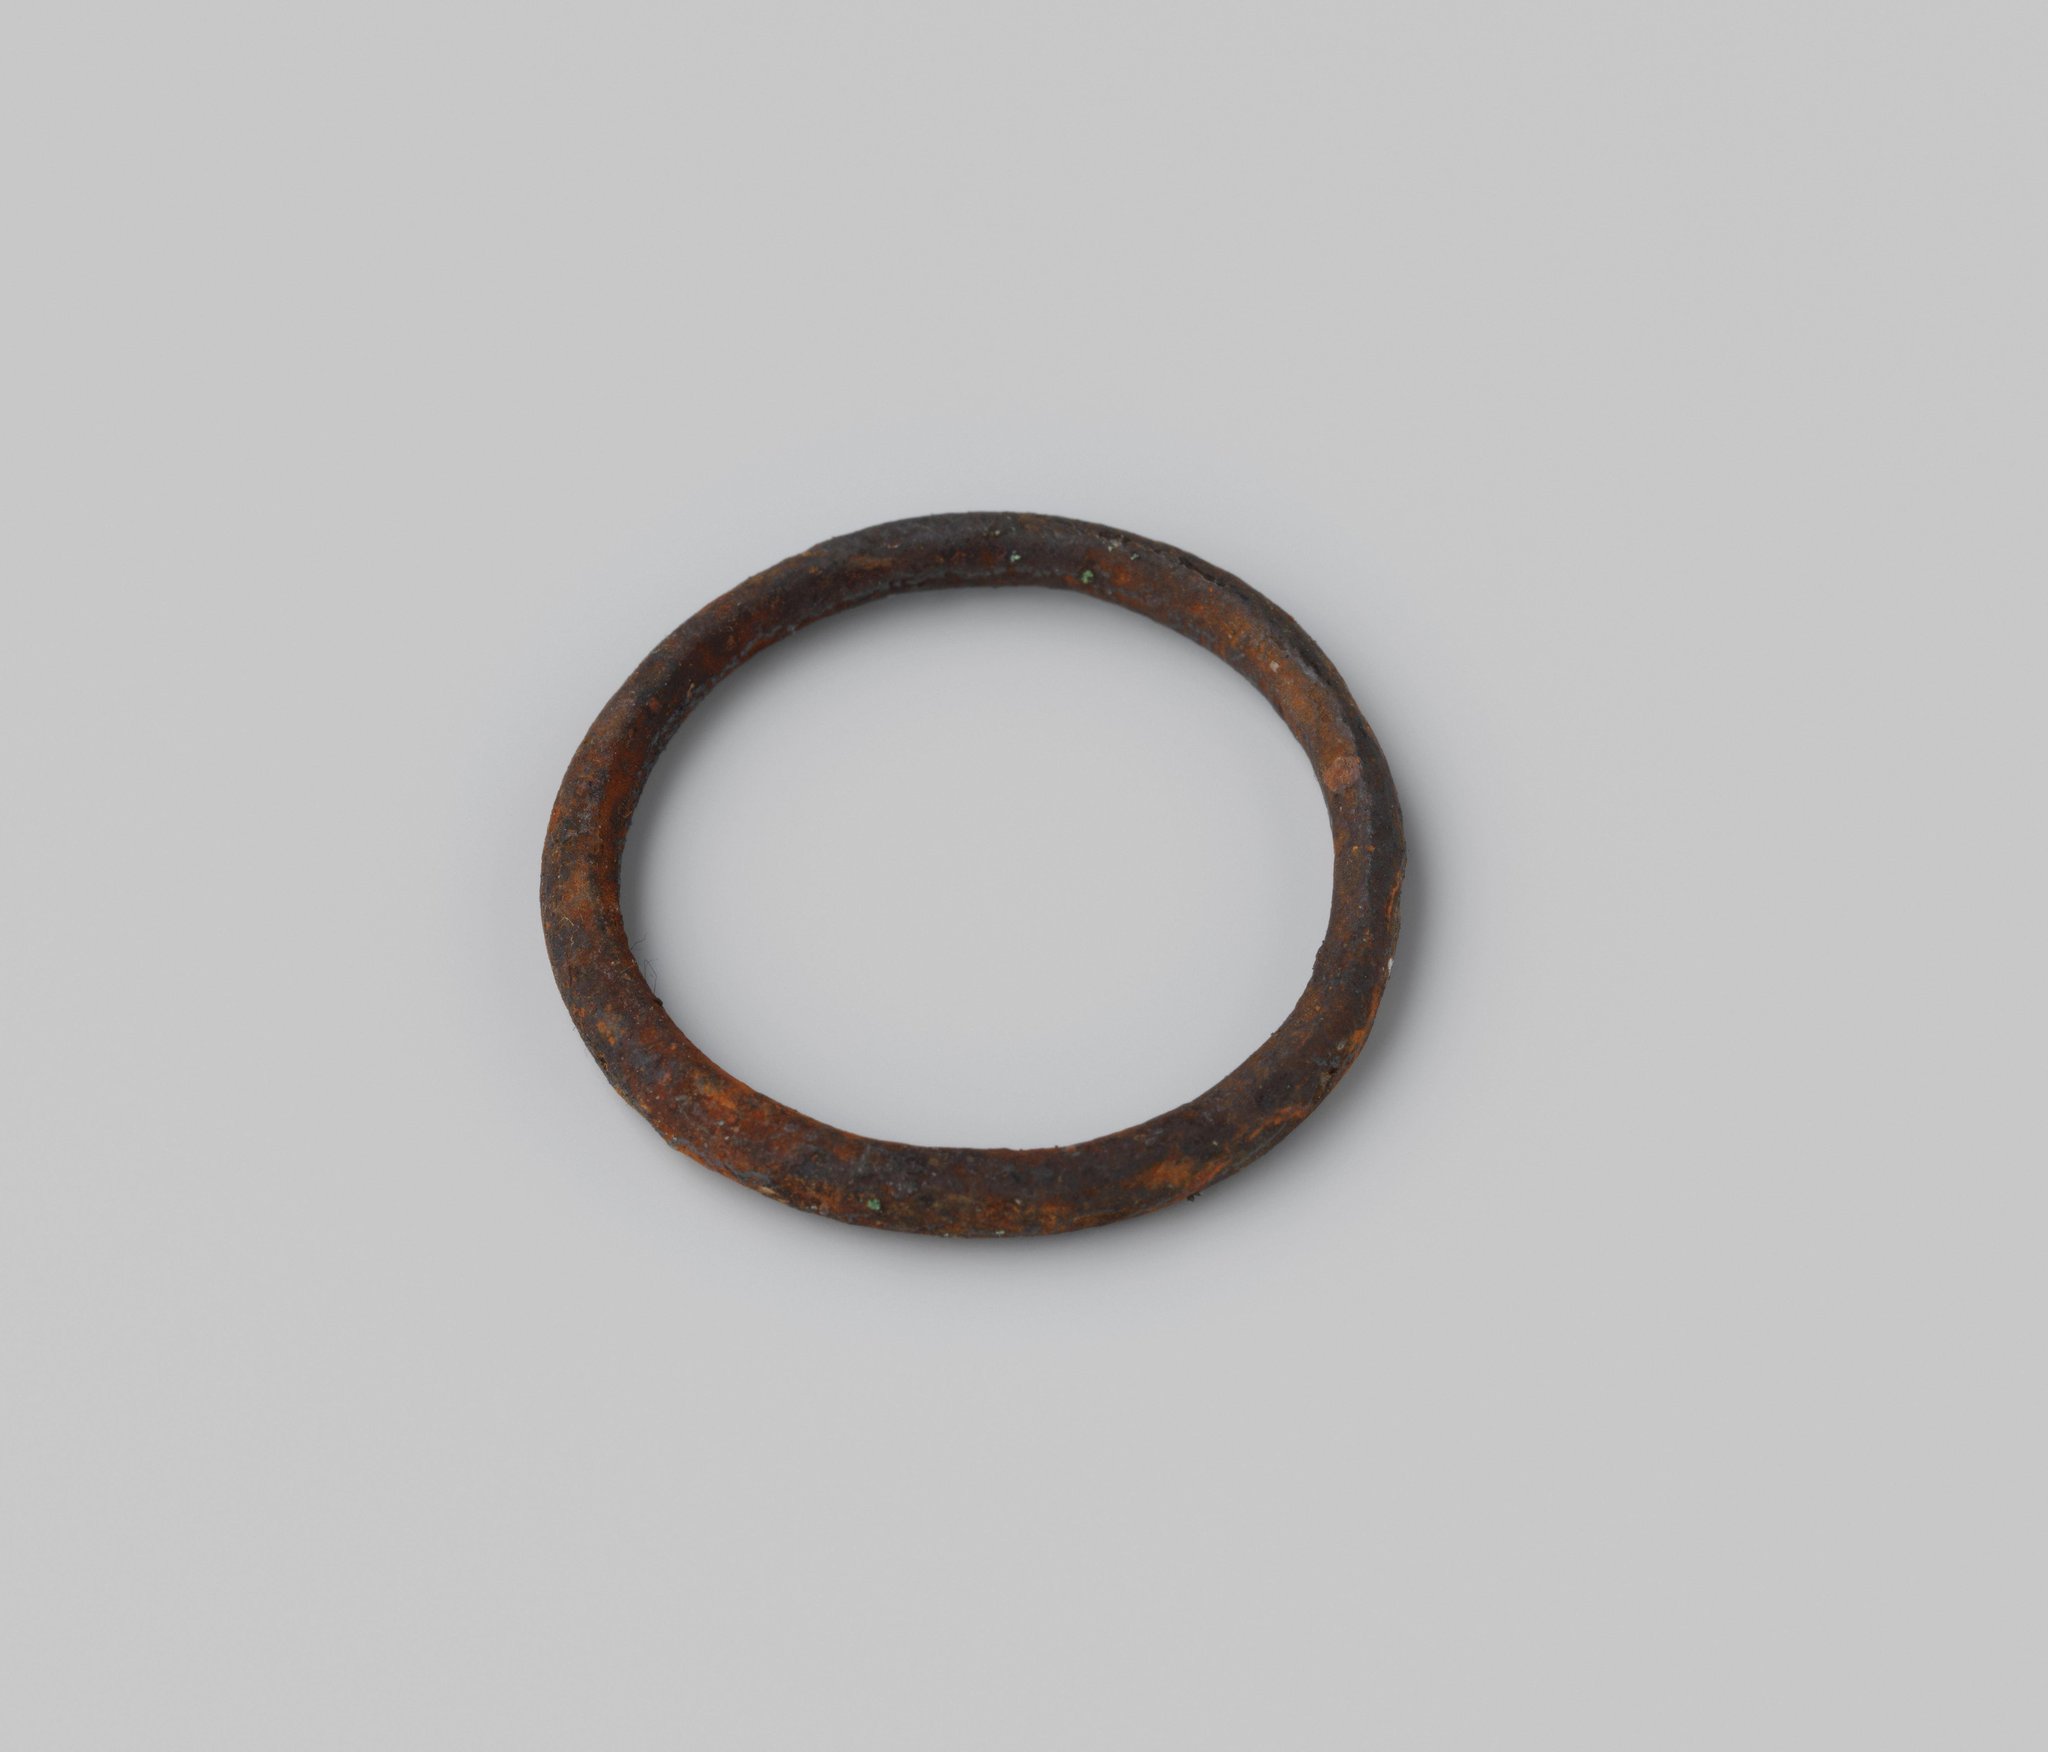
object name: fragment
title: Ringvormig fragment uit het wrak van de Oost-Indiëvaarder Hollandia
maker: Anonymous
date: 1700-1743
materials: copper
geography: netherlands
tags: verenigde oostindische compagnie, hollandia (schip), annet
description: Varied parts or fragments, rings or ring-shaped fragments; id. 80H946.